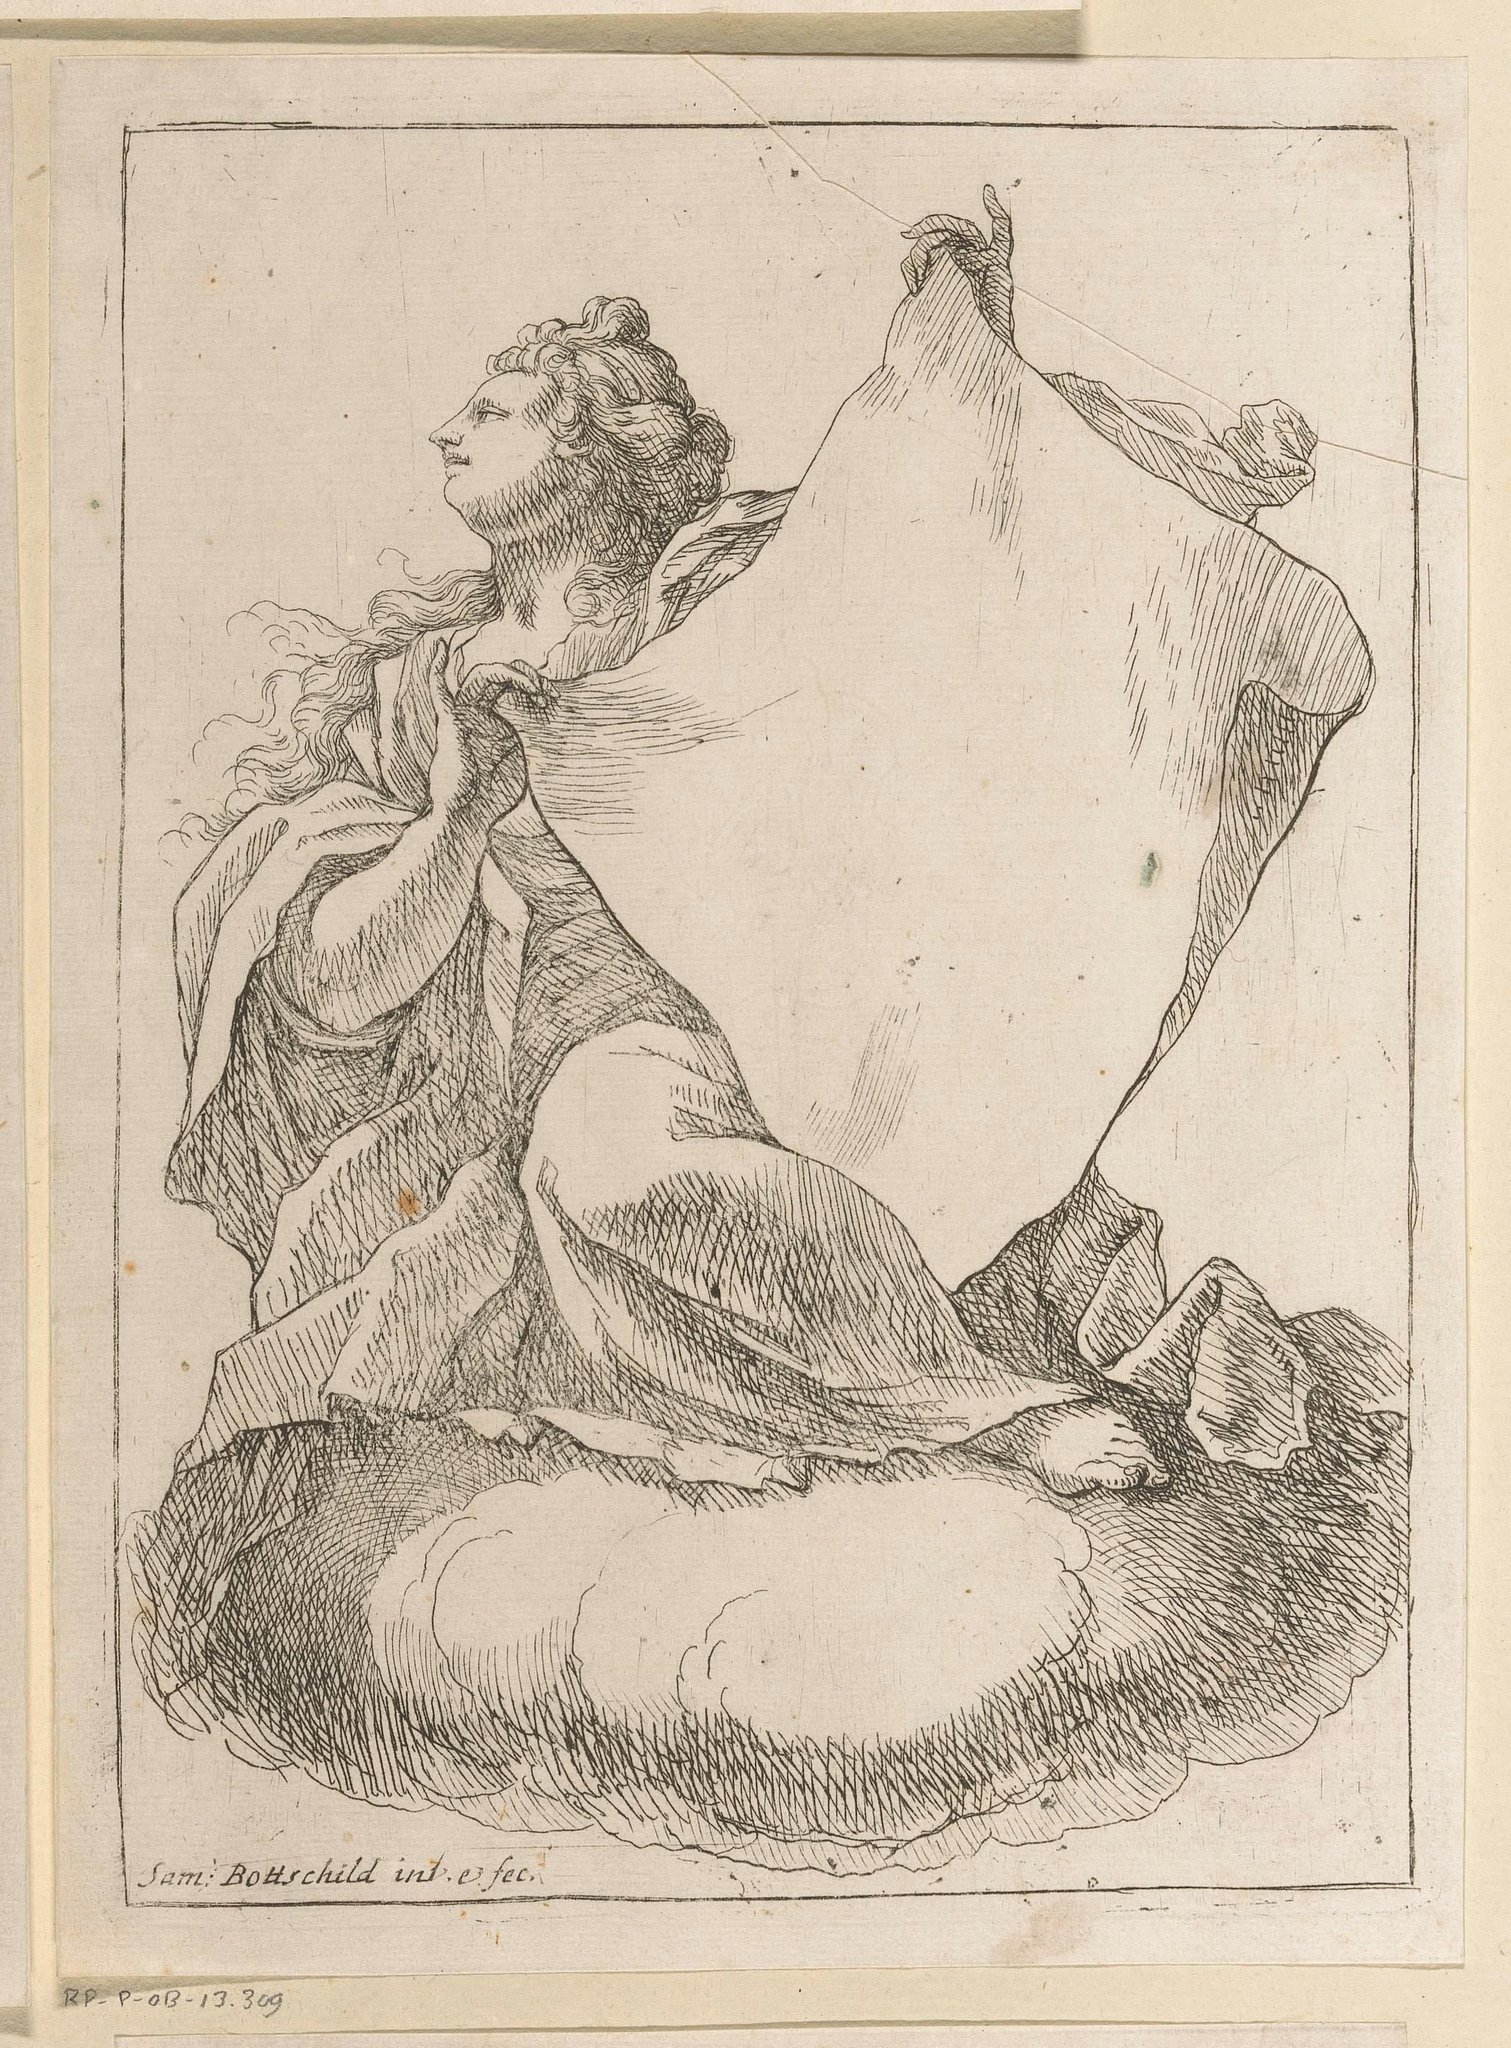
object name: print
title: Vrouw met een doek in haar handen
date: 1693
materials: paper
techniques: etching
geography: dresden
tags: sitting or standing on clouds, ribbon, scroll, banderole ~ ornament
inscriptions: collector's mark: Lugt 240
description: Prent afkomstig uit de serie 'Opera Varia Historica, Poetica & Iconologica', uitgegeven in 1693. Deze serie omvat vrijwel het complete oeuvre van de kunstenaar en bestaat uit 48 prenten, voornamelijk ontwerpen voor plafonds.